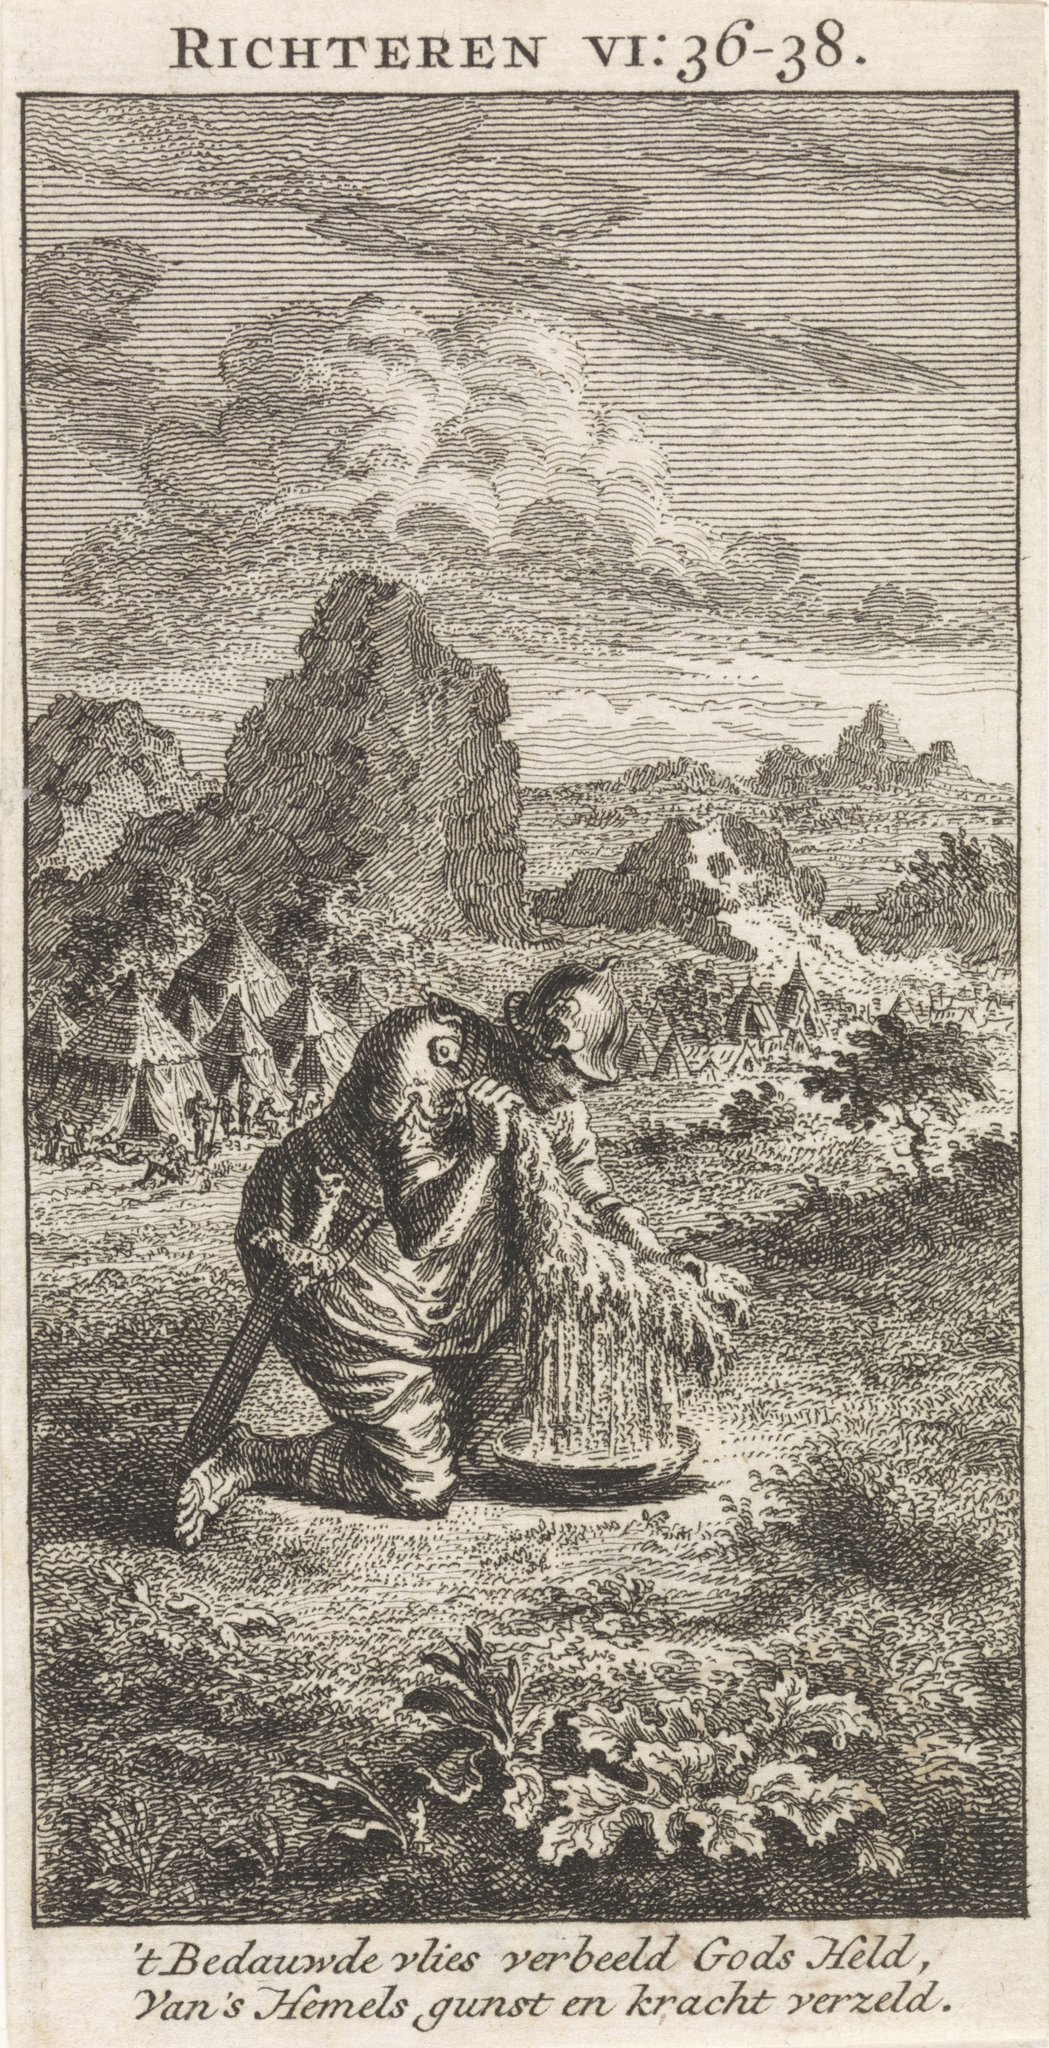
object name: print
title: Gideon en de natte schaapsvacht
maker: Anonymous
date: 1712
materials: paper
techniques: etching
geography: amsterdam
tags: gideon presses the fleece and wrings out a bowl full of water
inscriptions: collector's mark: Lugt 240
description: Kopie van illustratie voor: Luyken, Jan. Bybel printen. Amsterdam: Pieter Arentsz. II (wed.) en Cornelis van der Sys, 1712, p. 8.